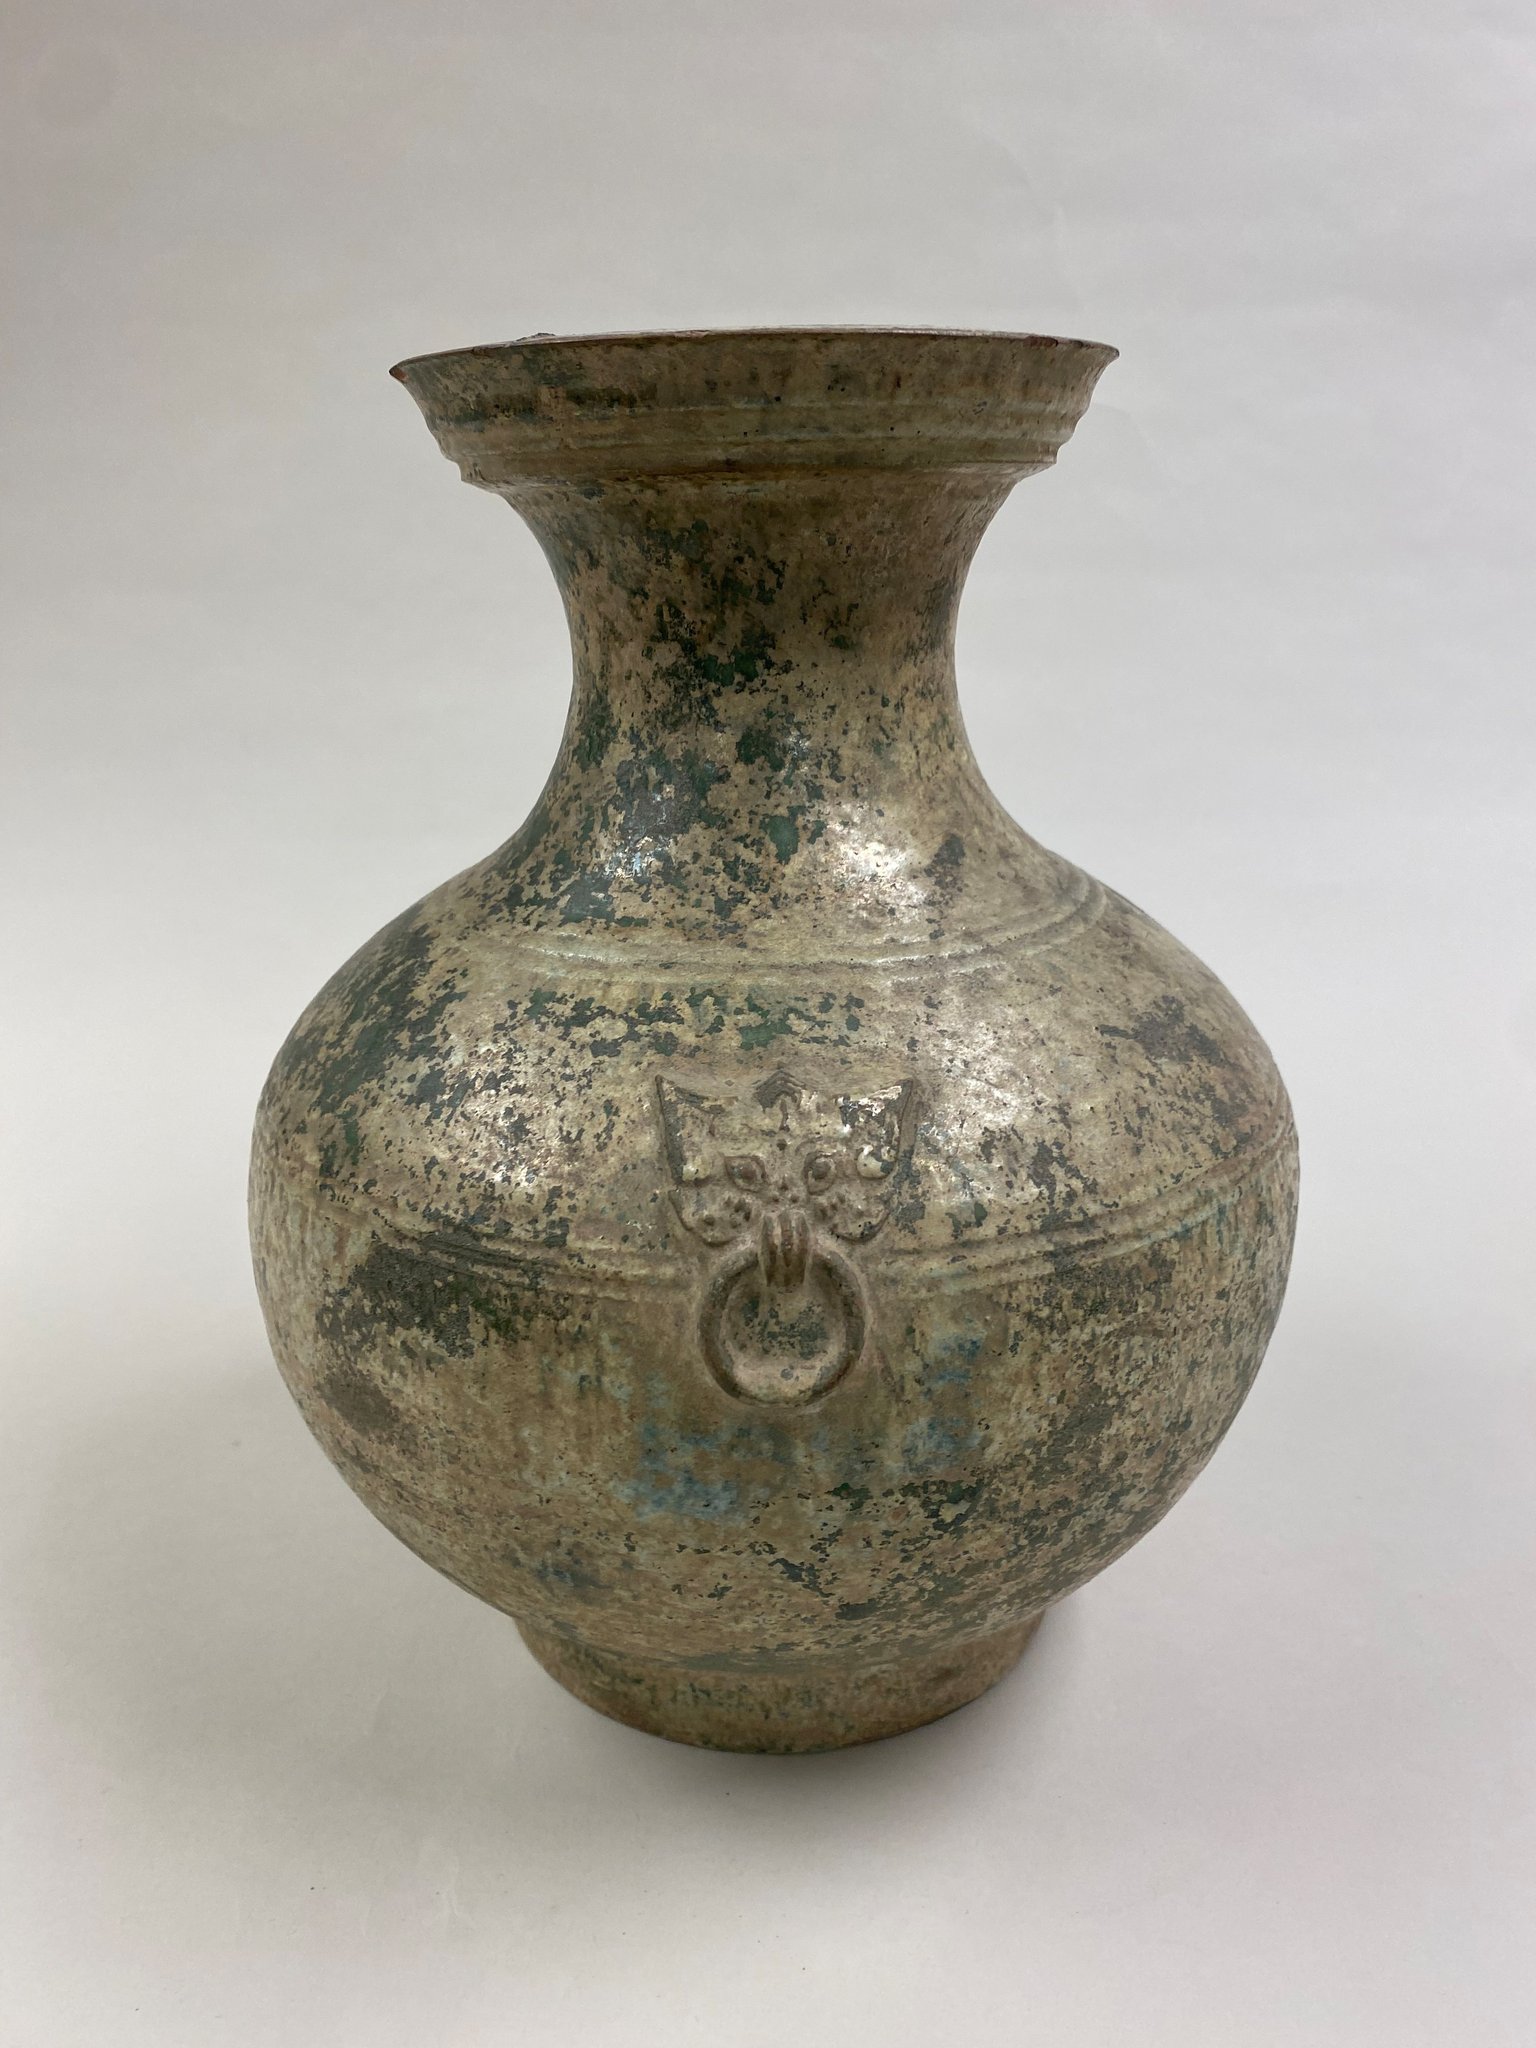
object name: vase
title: Wine container (hu)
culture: chinese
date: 1-200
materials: earthenware, glaze, lead